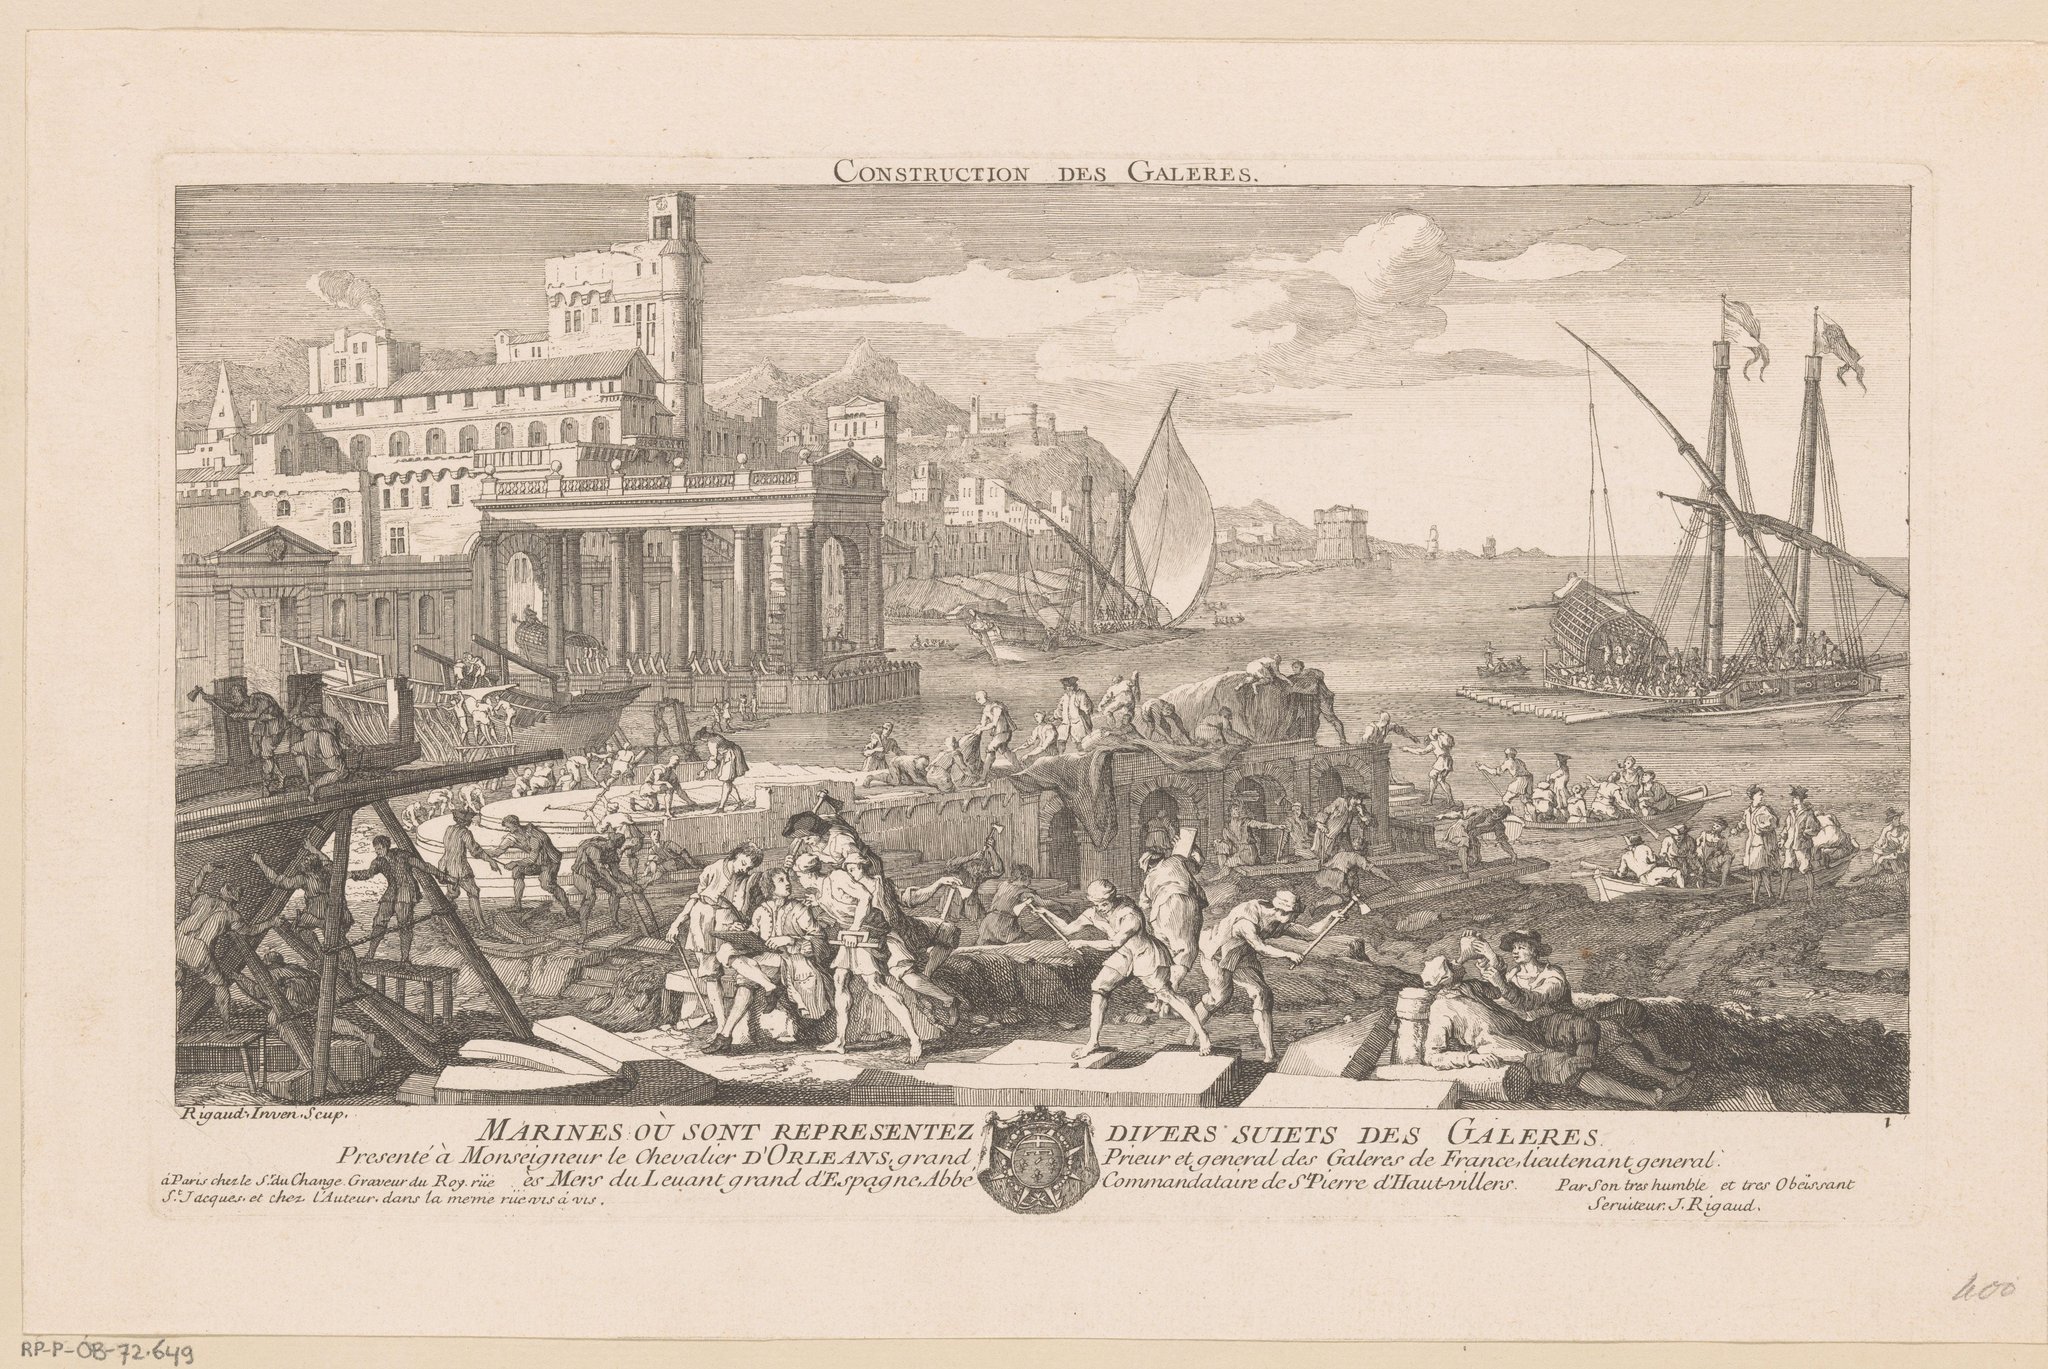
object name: print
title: Marines où sont representez divers sujets des Galeres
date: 1720-1754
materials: paper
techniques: engraving, etching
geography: paris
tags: shipyard, shipdock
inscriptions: collector's mark: Lugt 240